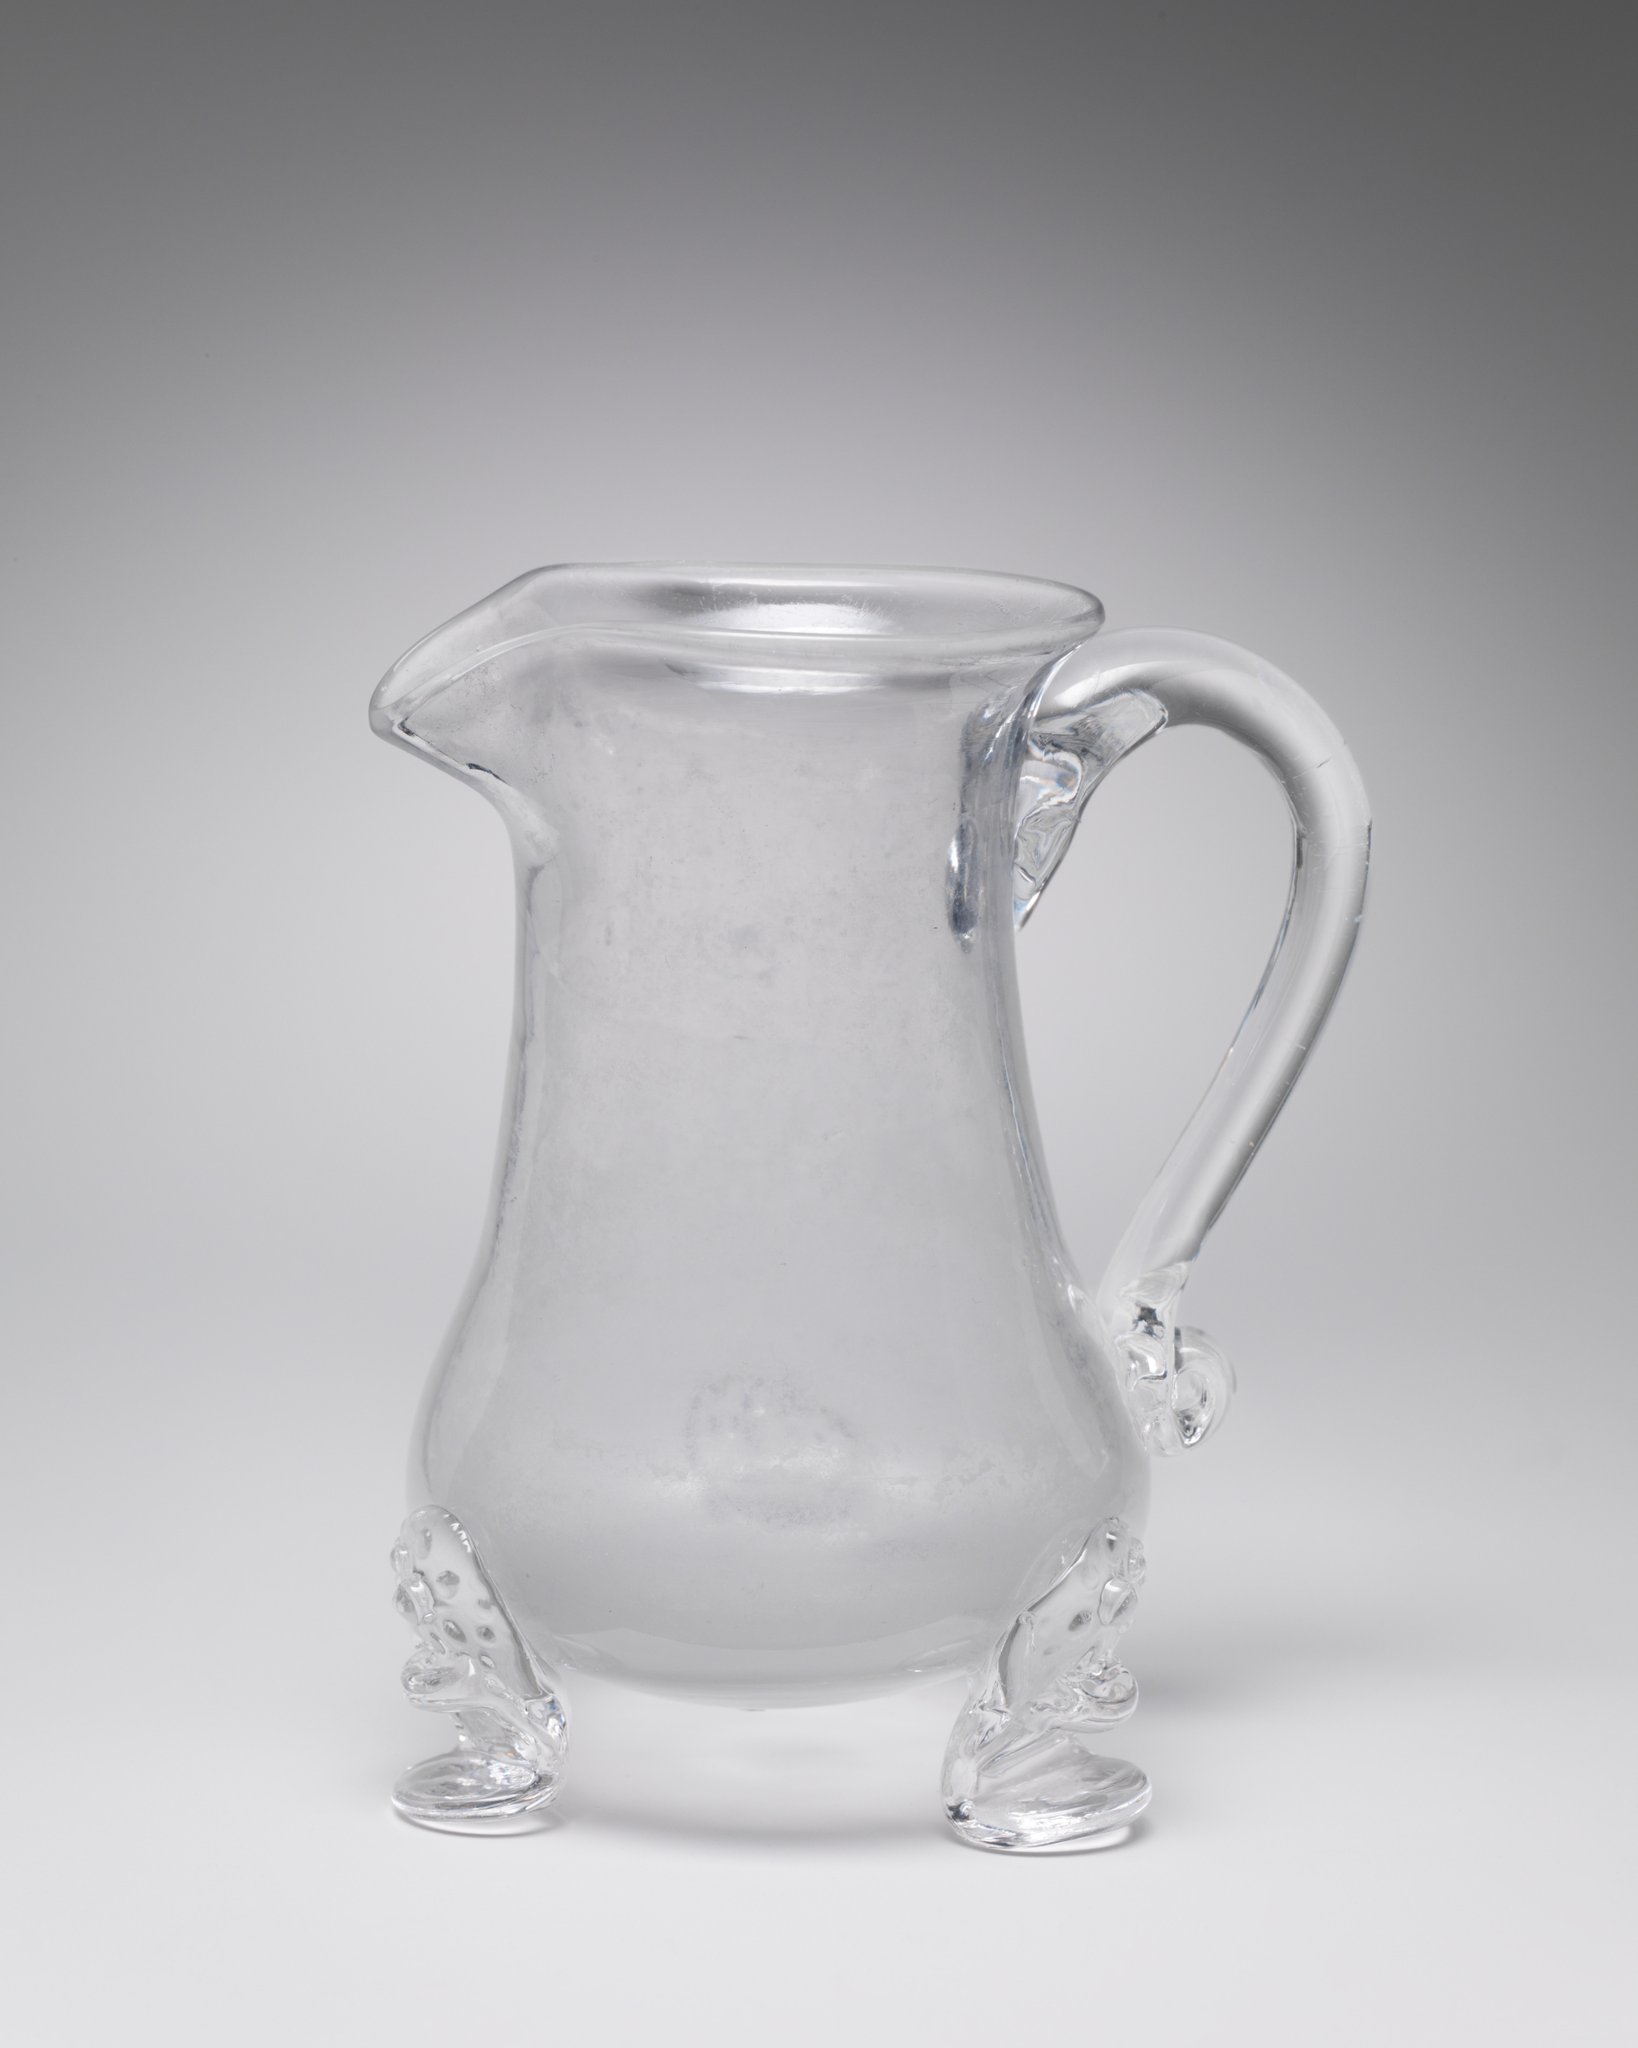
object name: creamer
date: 1740-1745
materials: glass